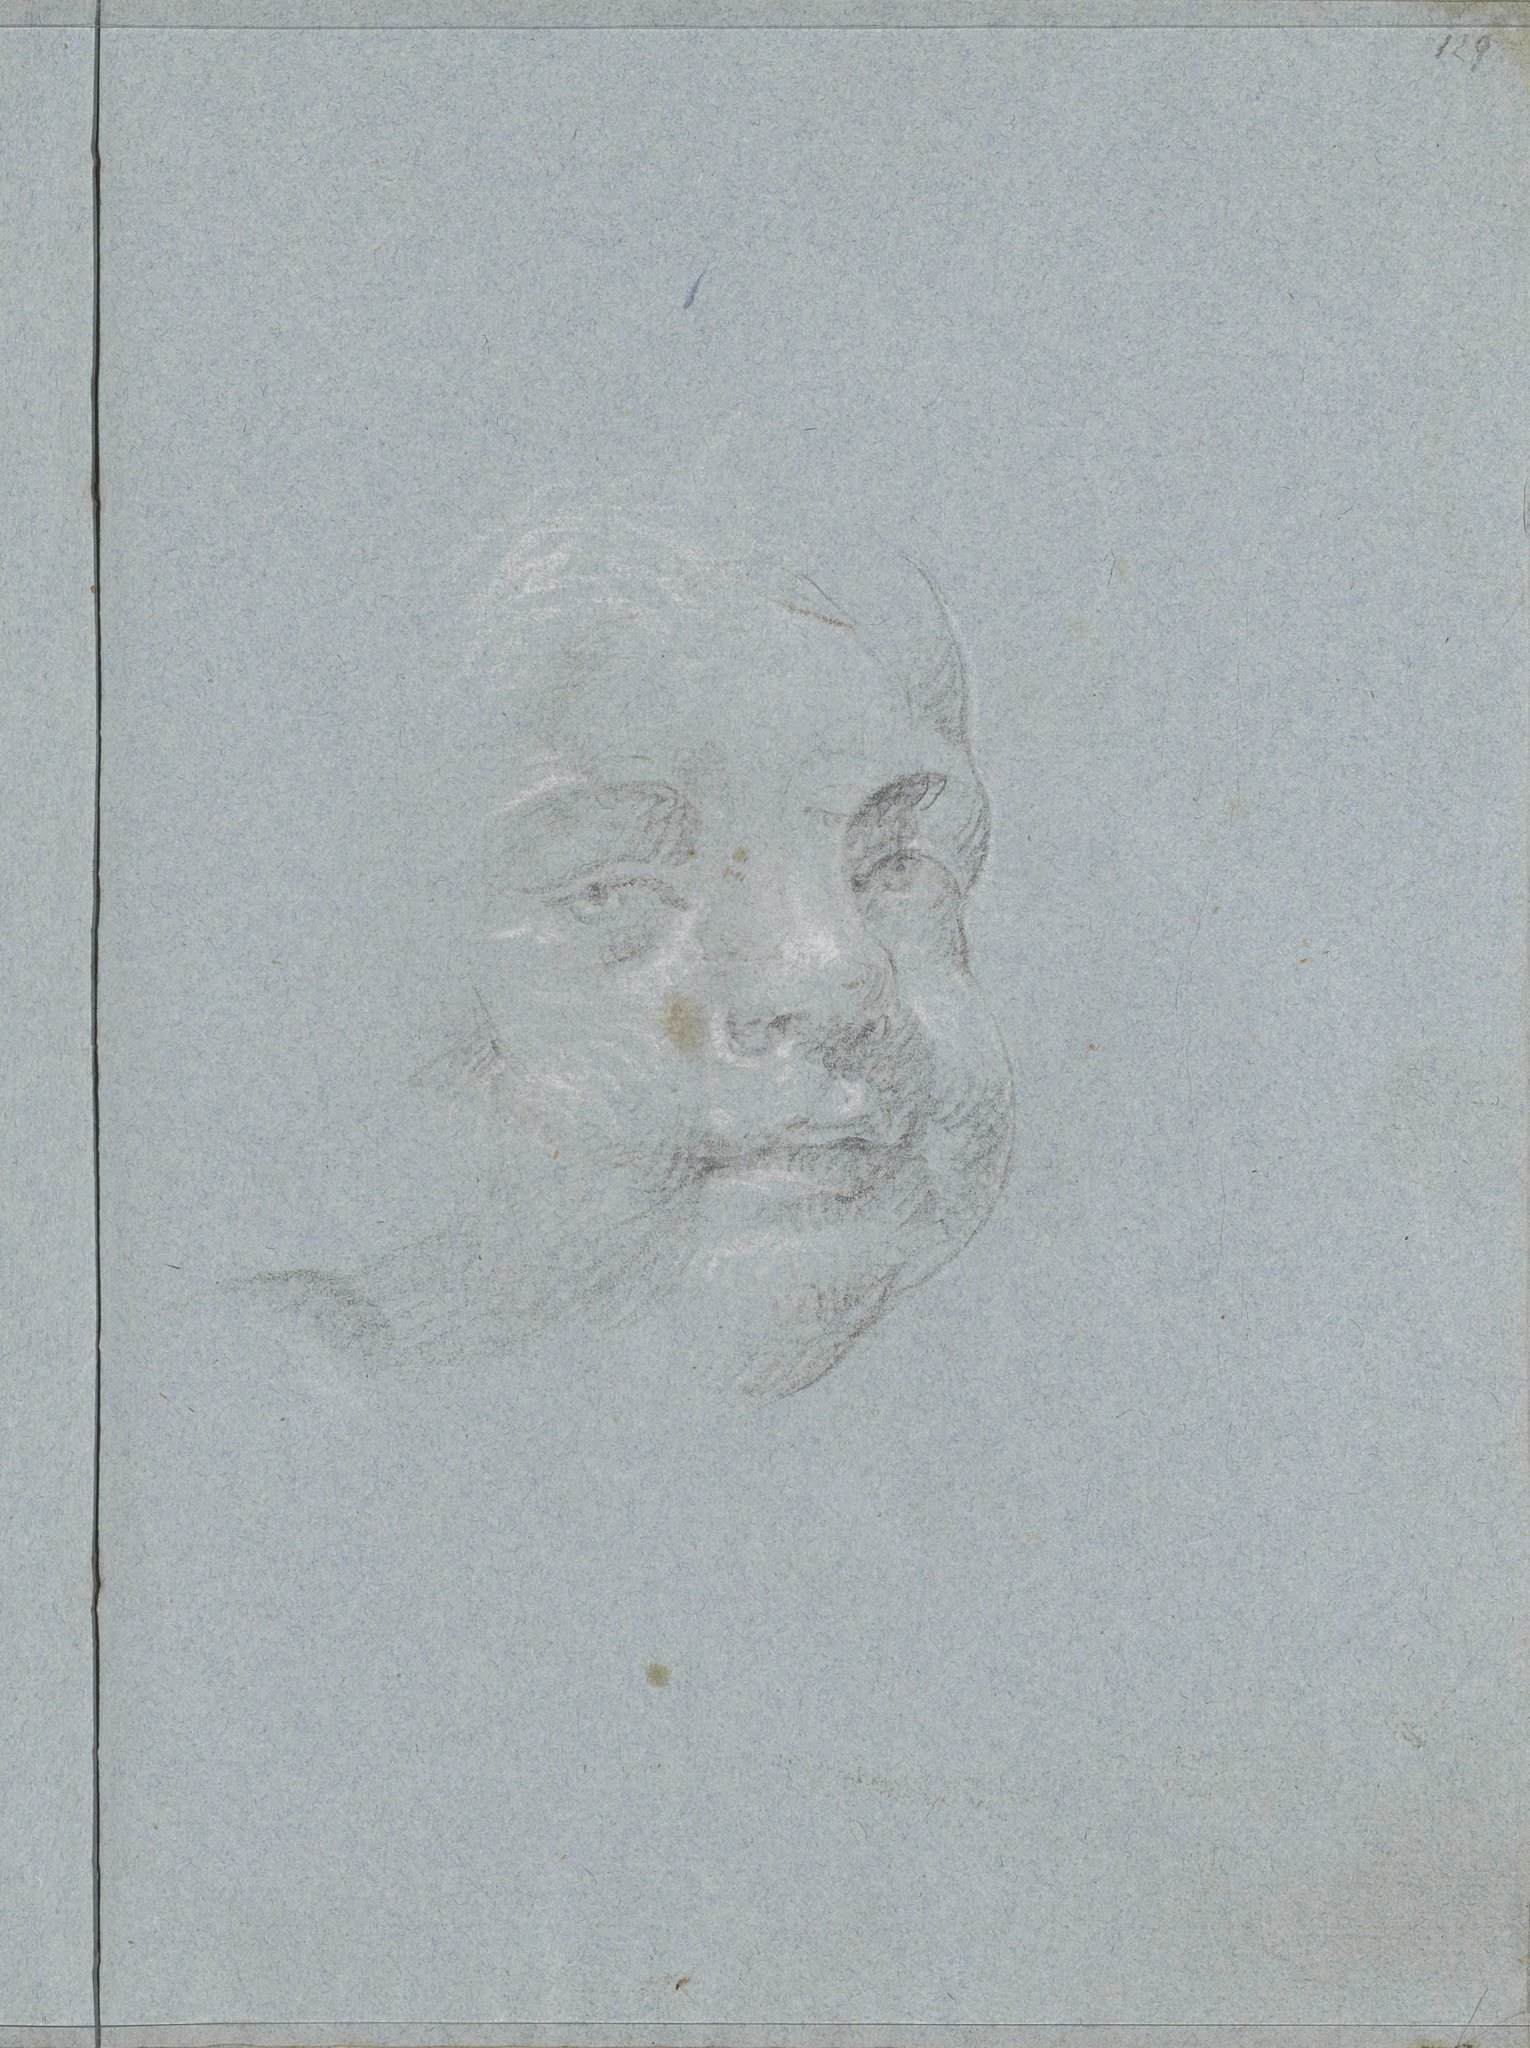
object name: sketchbook leaf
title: Kop van een putto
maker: lorenzo baldissera tiepolo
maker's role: draughtsman, print maker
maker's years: 1736-1776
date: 1751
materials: chalk, paper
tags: head (human), cupids: 'amores', 'amoretti', 'putti'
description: Bladzijde 129 uit een schetsboek met 158 bladzijden.